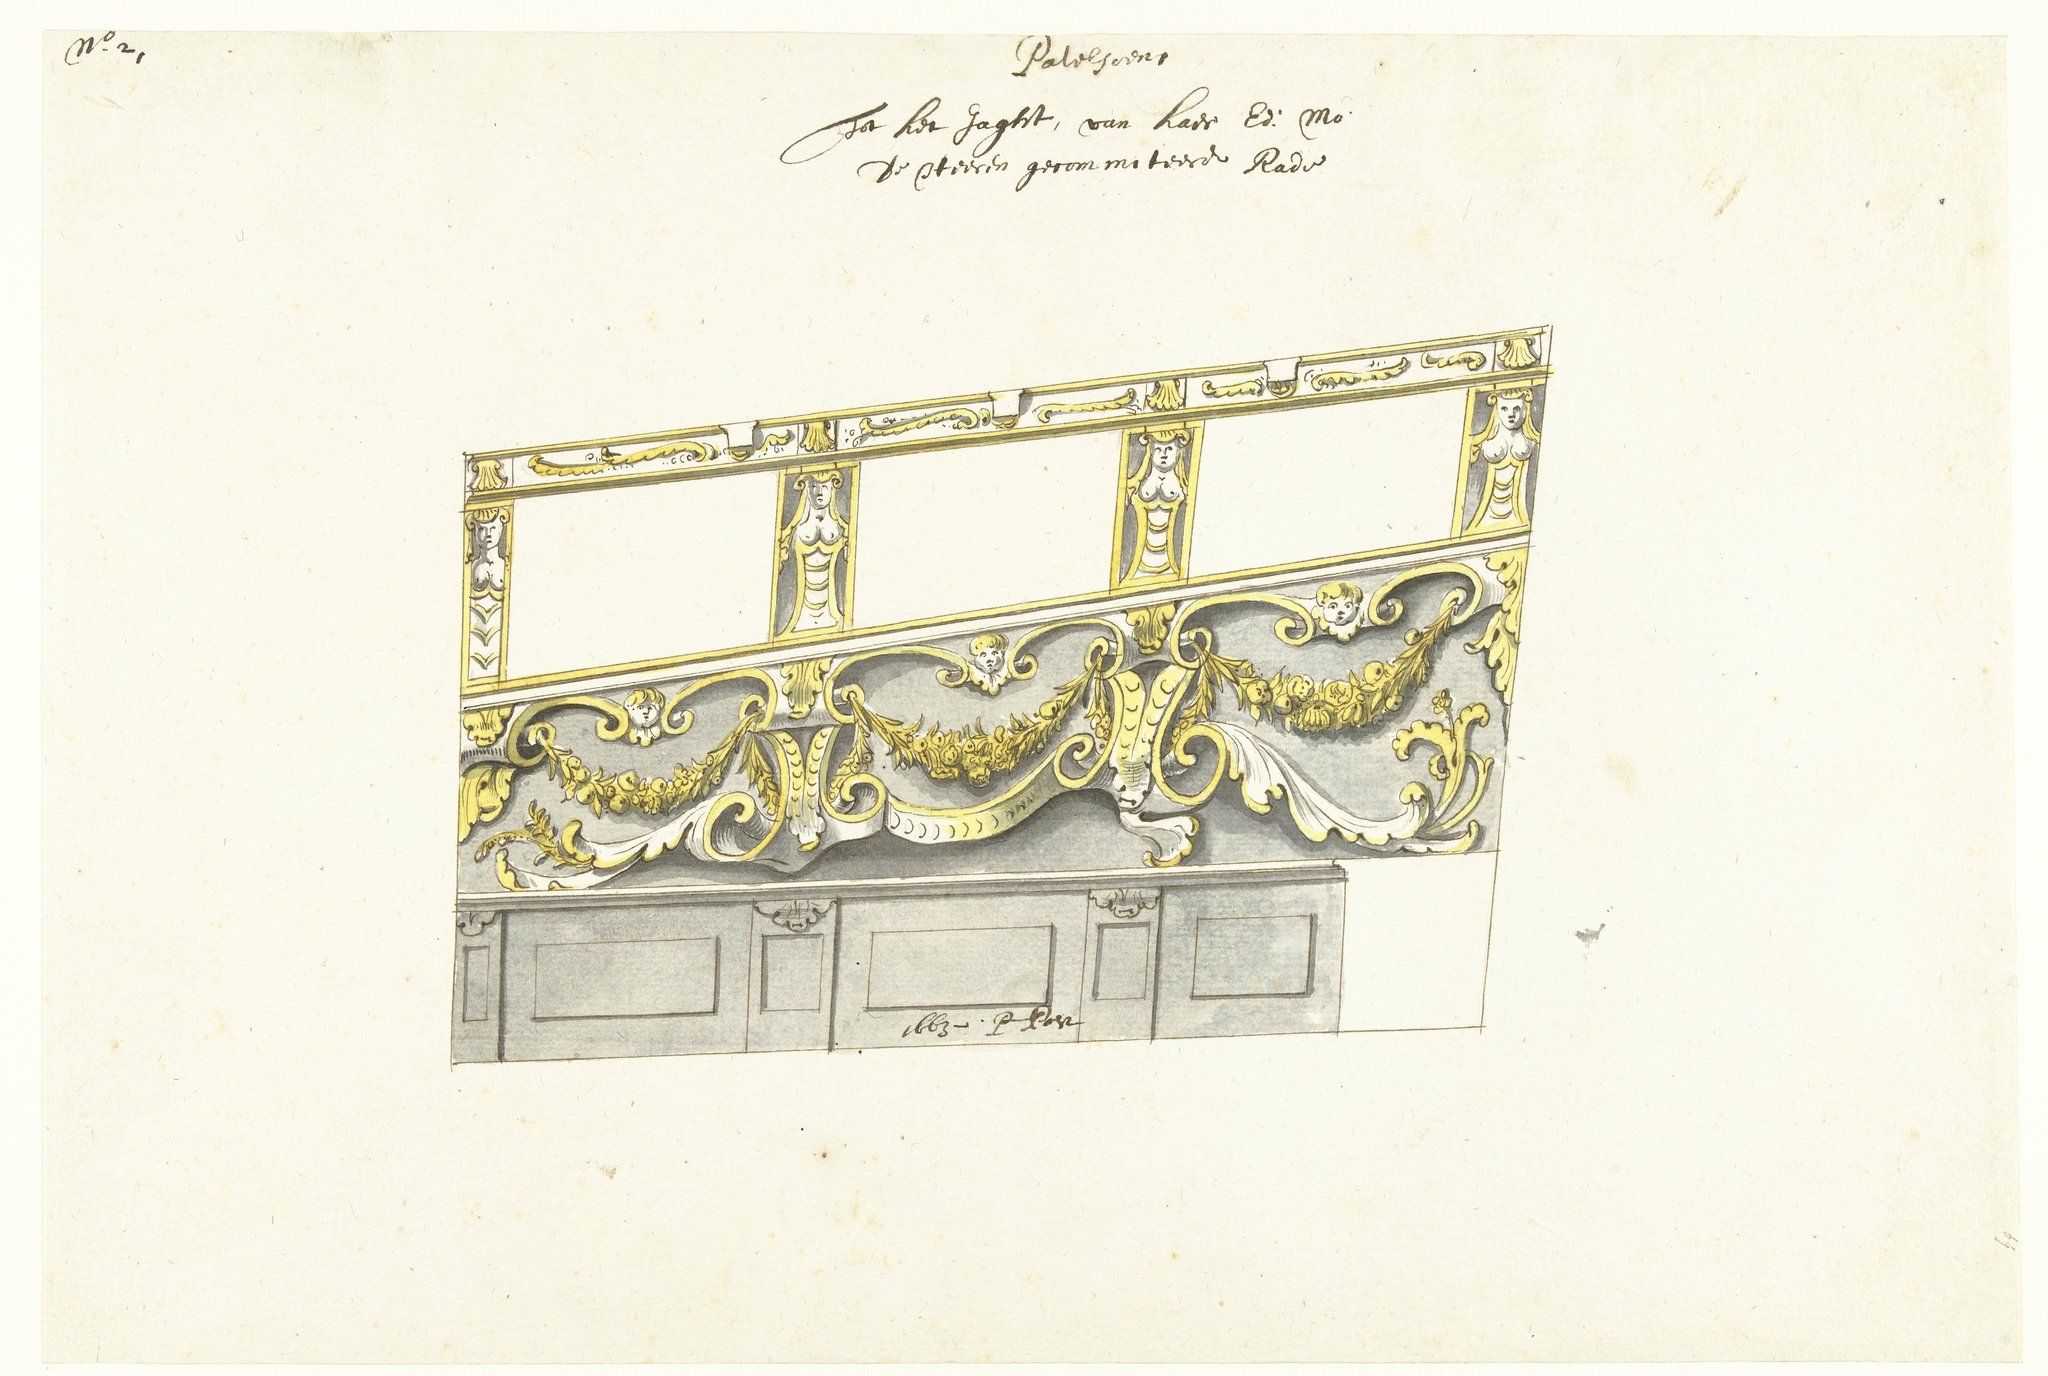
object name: drawing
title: Interieurdecoraties van het statenjacht der Gecommitteerde Raden van Holland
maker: pieter jansz. post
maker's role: draughtsman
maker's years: 1608-1669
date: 1663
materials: ink, paper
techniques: brush, pen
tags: anthropomorphic ornament, parts of ship's interior, wall-covering, ornament ~ festoon, garland, ornament derived from plant forms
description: Ontwerpen voor decoraties van het interieur van het statenjacht van de Gecommitteerde Raden van Holland: paviljoen, zijwand met guirlandes onder drie ramen.